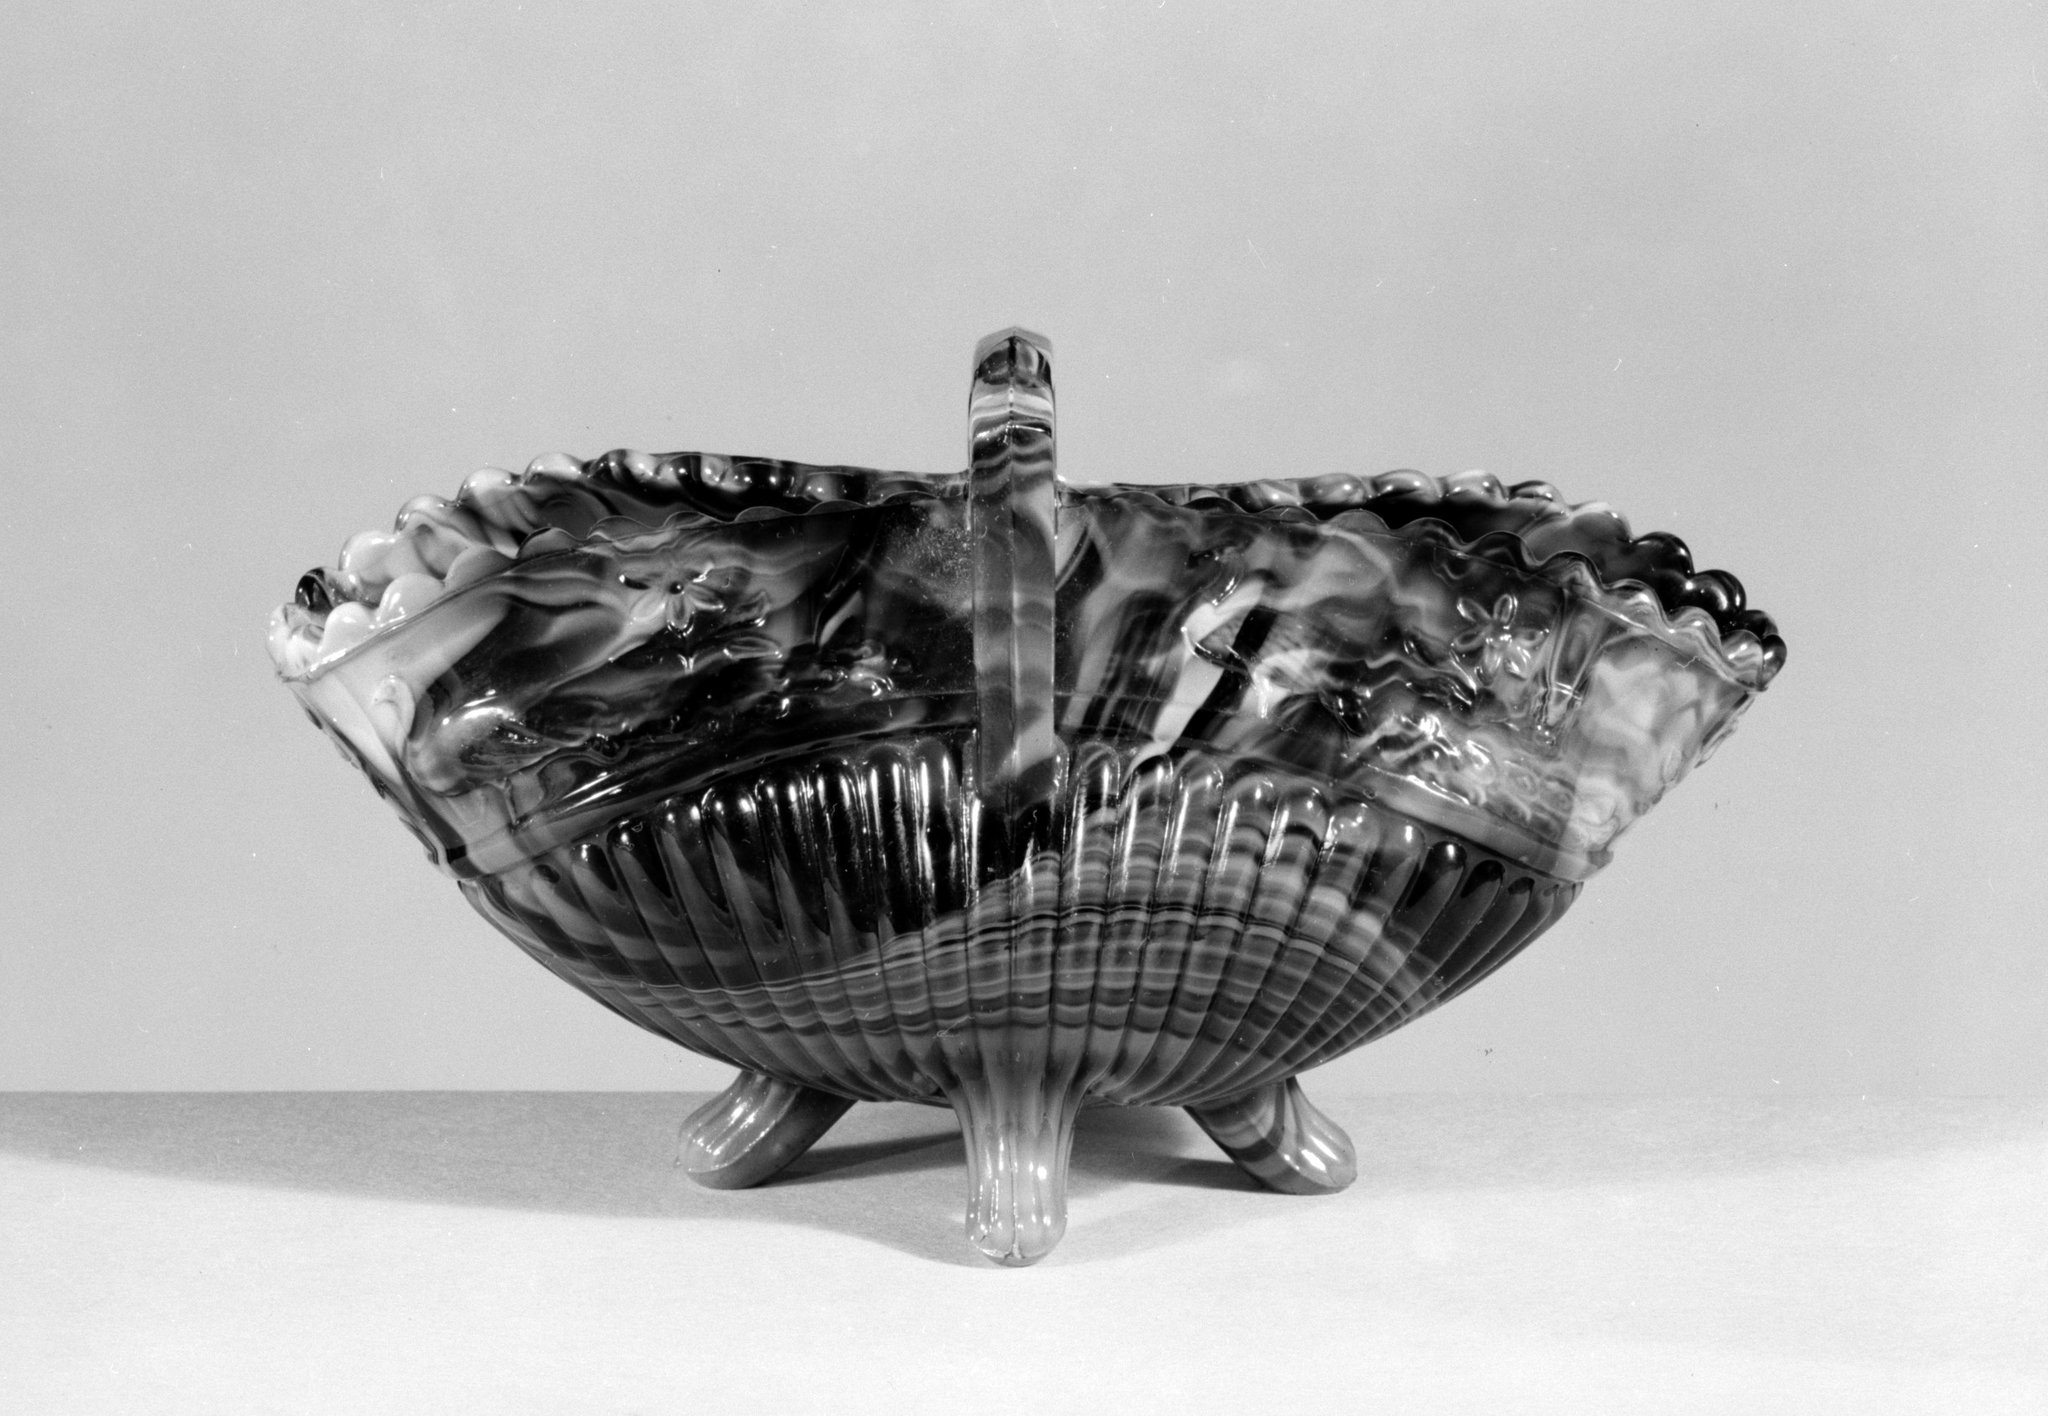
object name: basket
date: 1880-1890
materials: glass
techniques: pressed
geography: england